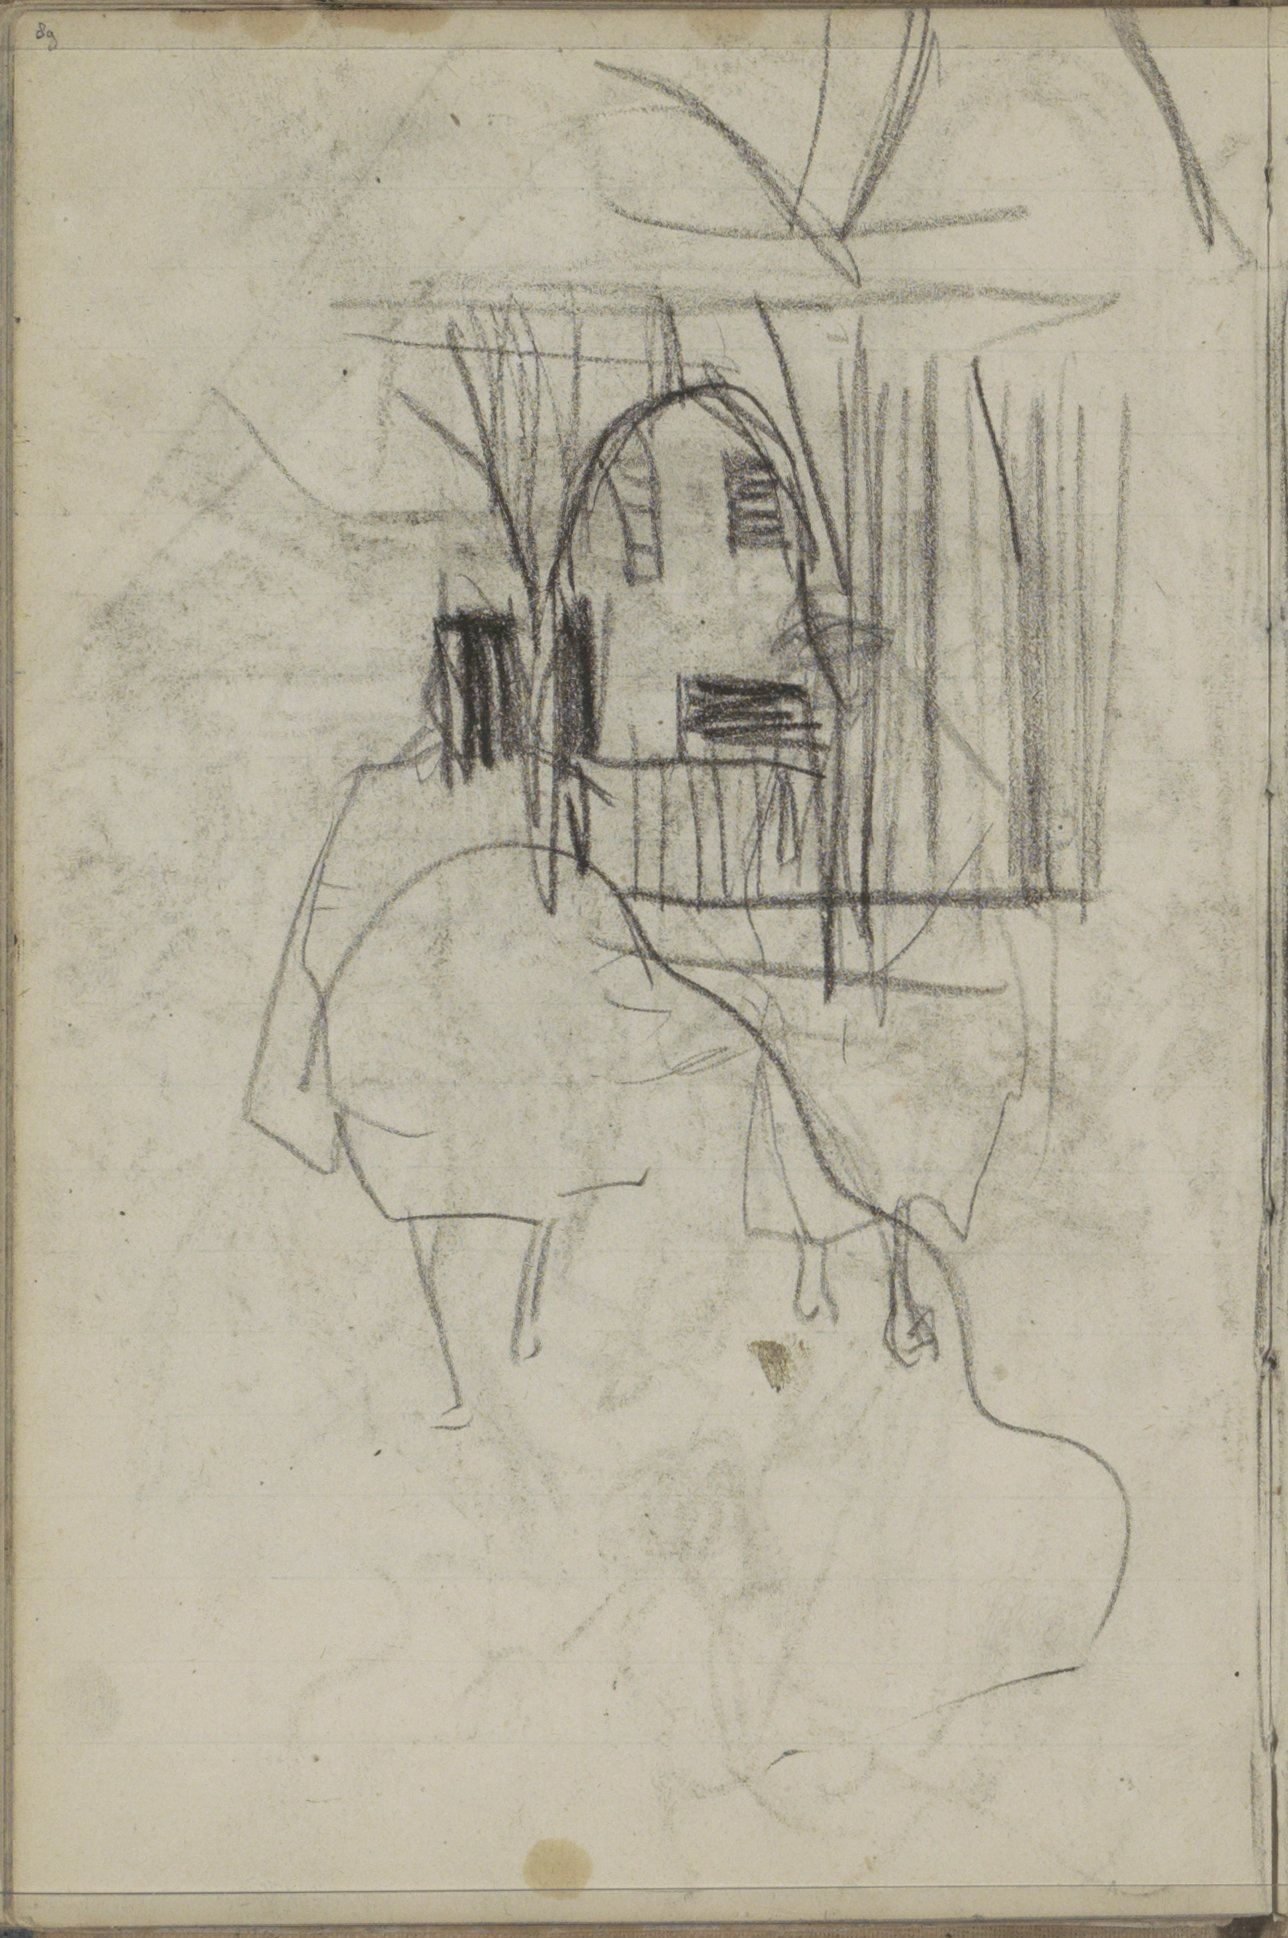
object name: sketchbook leaf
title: Architectuurstudie en twee figuren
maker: marius bauer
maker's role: draughtsman, print maker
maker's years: 1867-1932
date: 1888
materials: chalk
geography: istanbul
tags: anatomy (non-medical), architecture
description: Pagina 89 uit een schetsboek met 58 bladen.